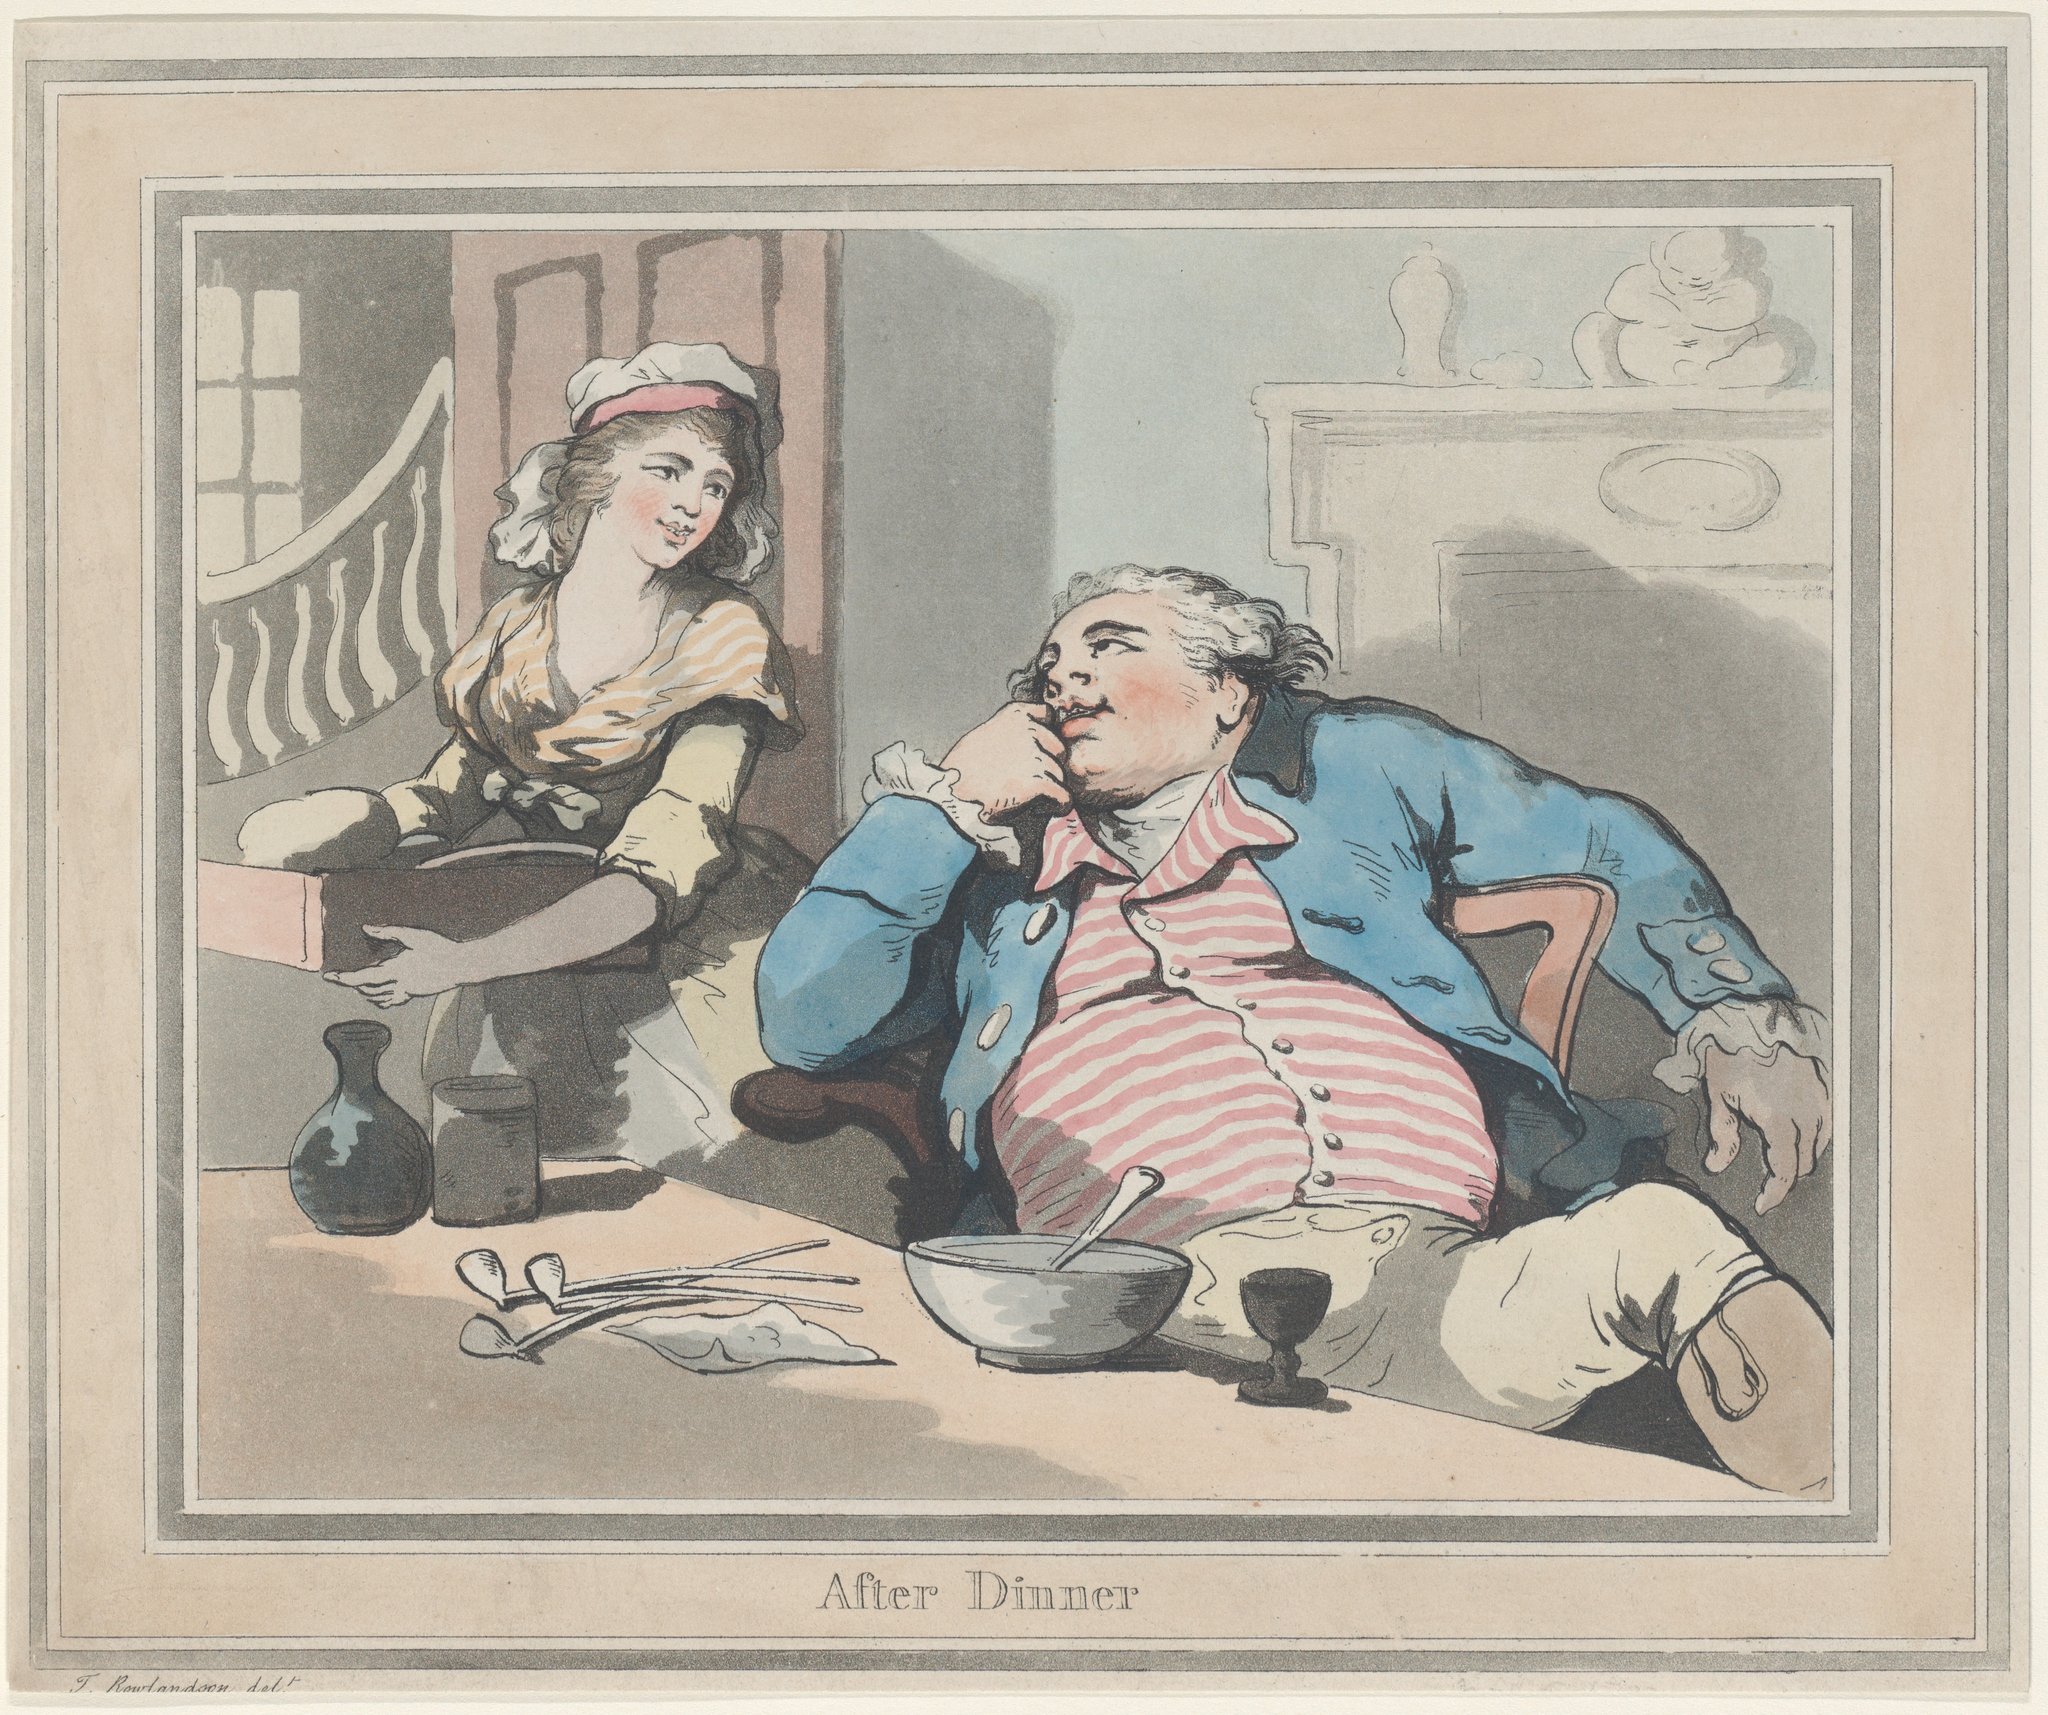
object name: print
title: After Dinner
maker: thomas rowlandson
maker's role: artist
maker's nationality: british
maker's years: 1757-1827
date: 1790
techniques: aquatint, etching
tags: men,women